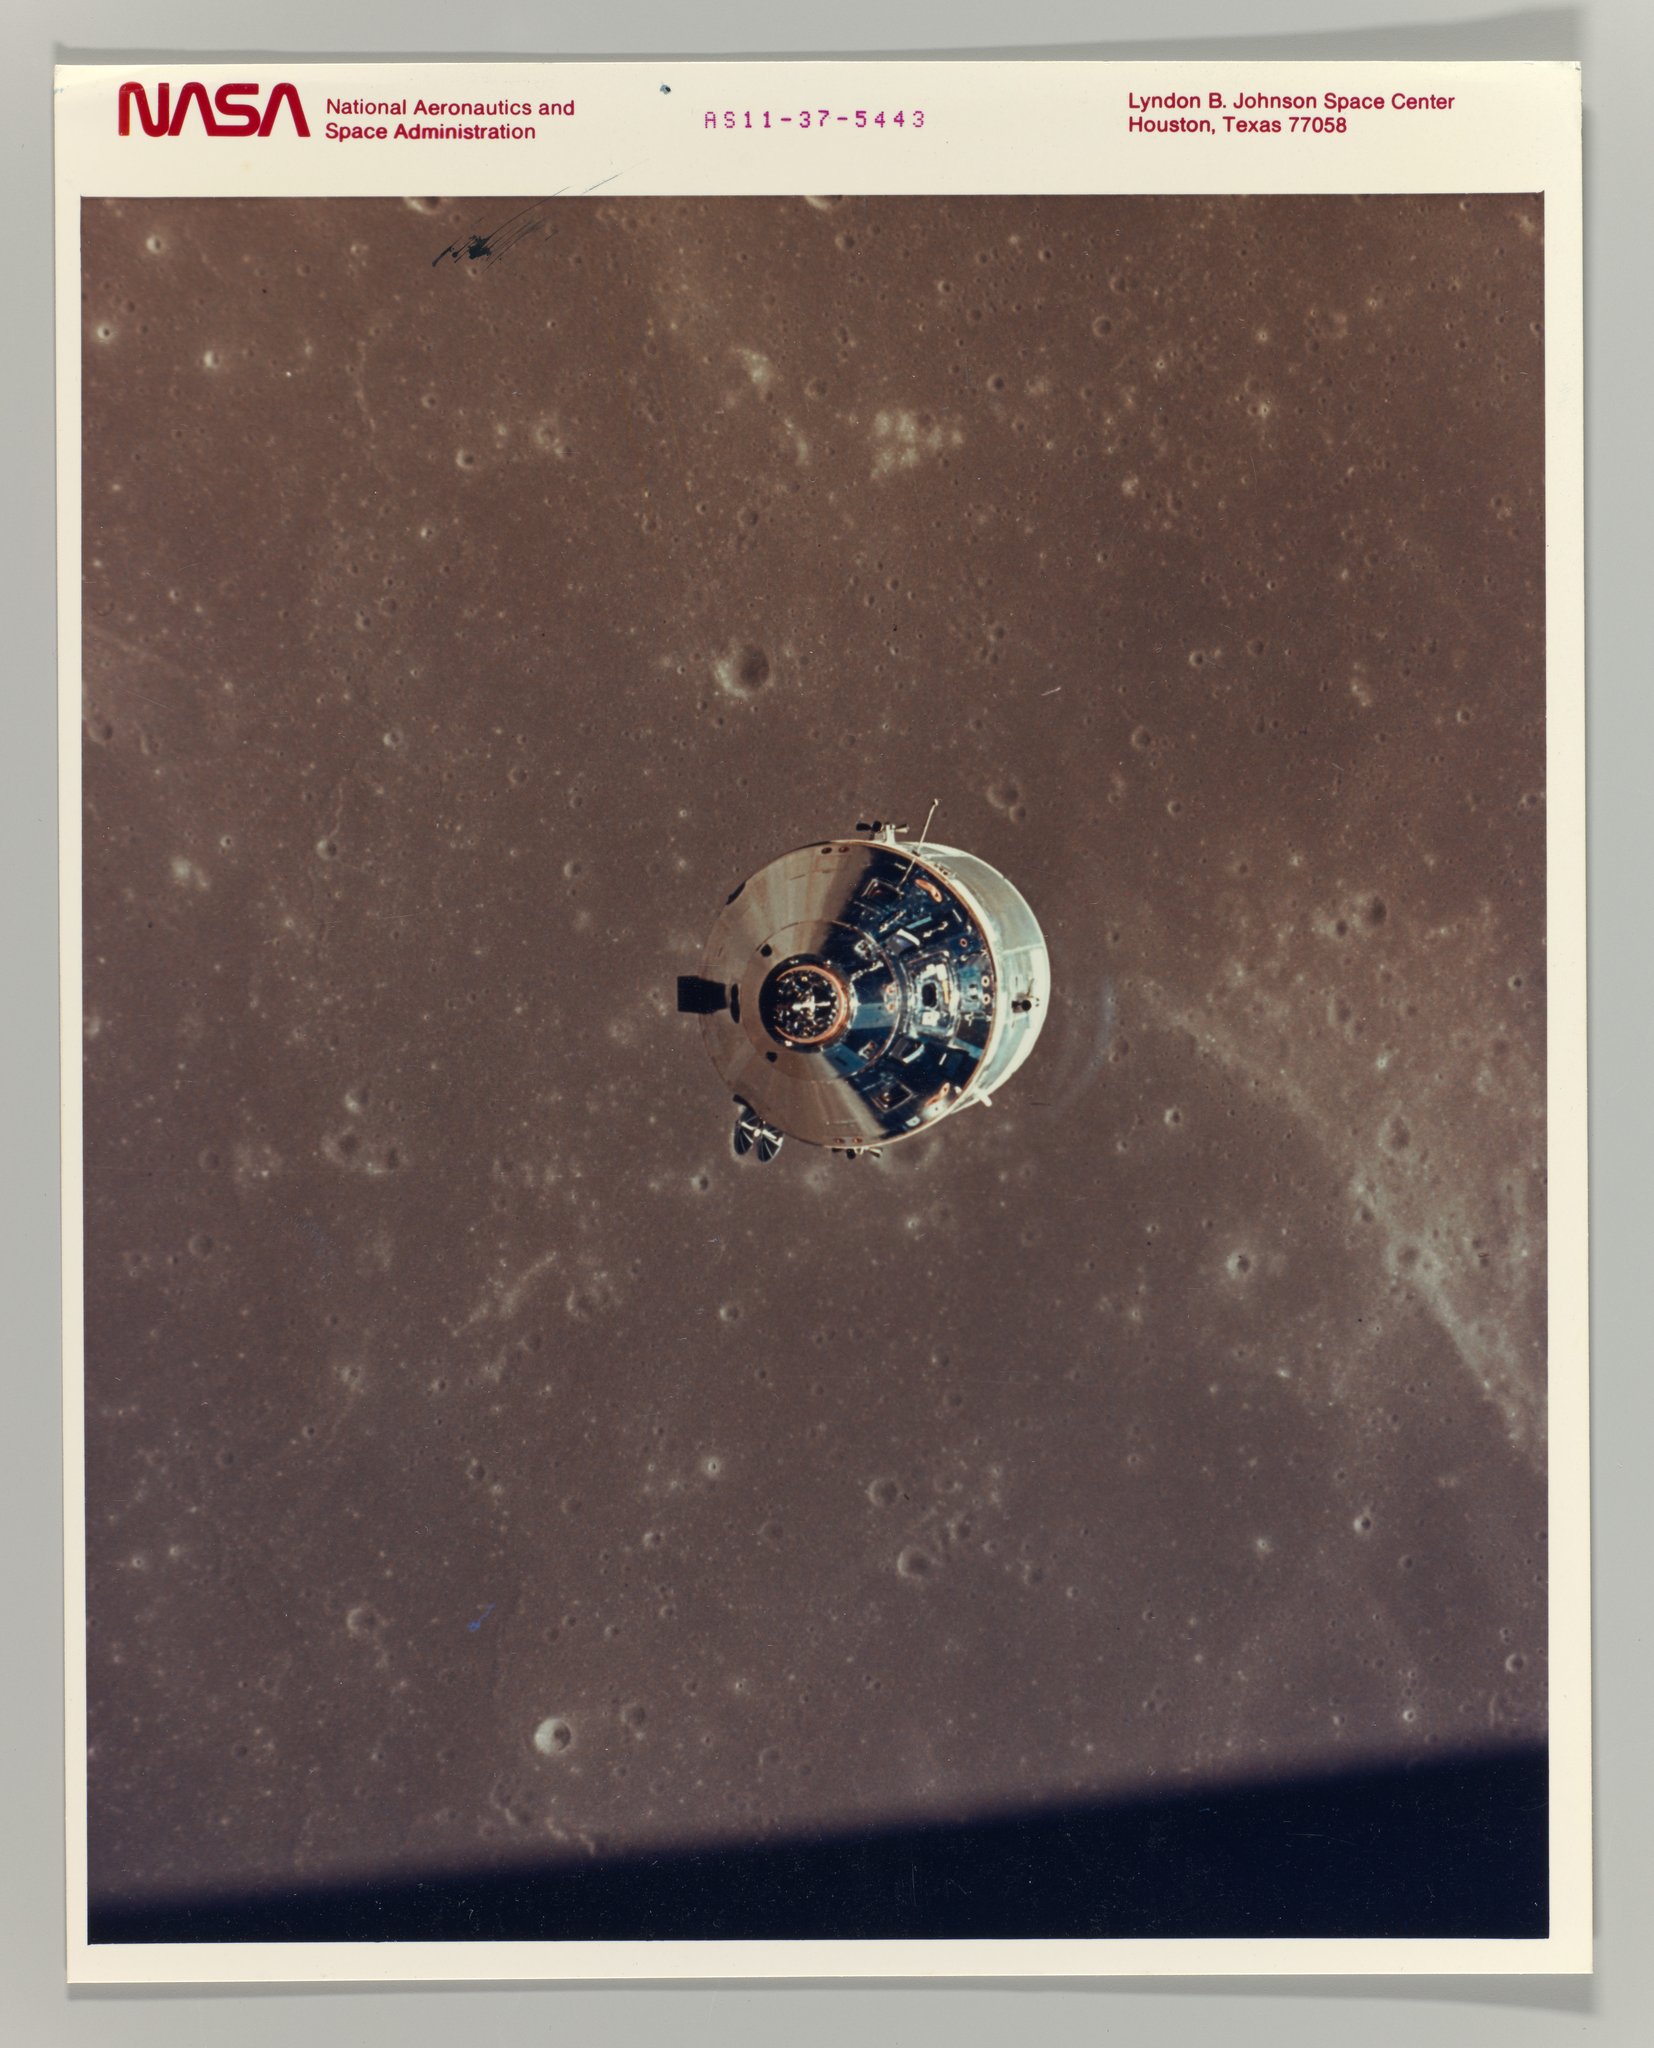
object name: photograph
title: Apollo 11 Command and Service Modules Photographed from the Lunar Module in Orbit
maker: national aeronautics and space administration (nasa)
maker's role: publisher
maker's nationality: american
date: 1969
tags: moon,astronomy